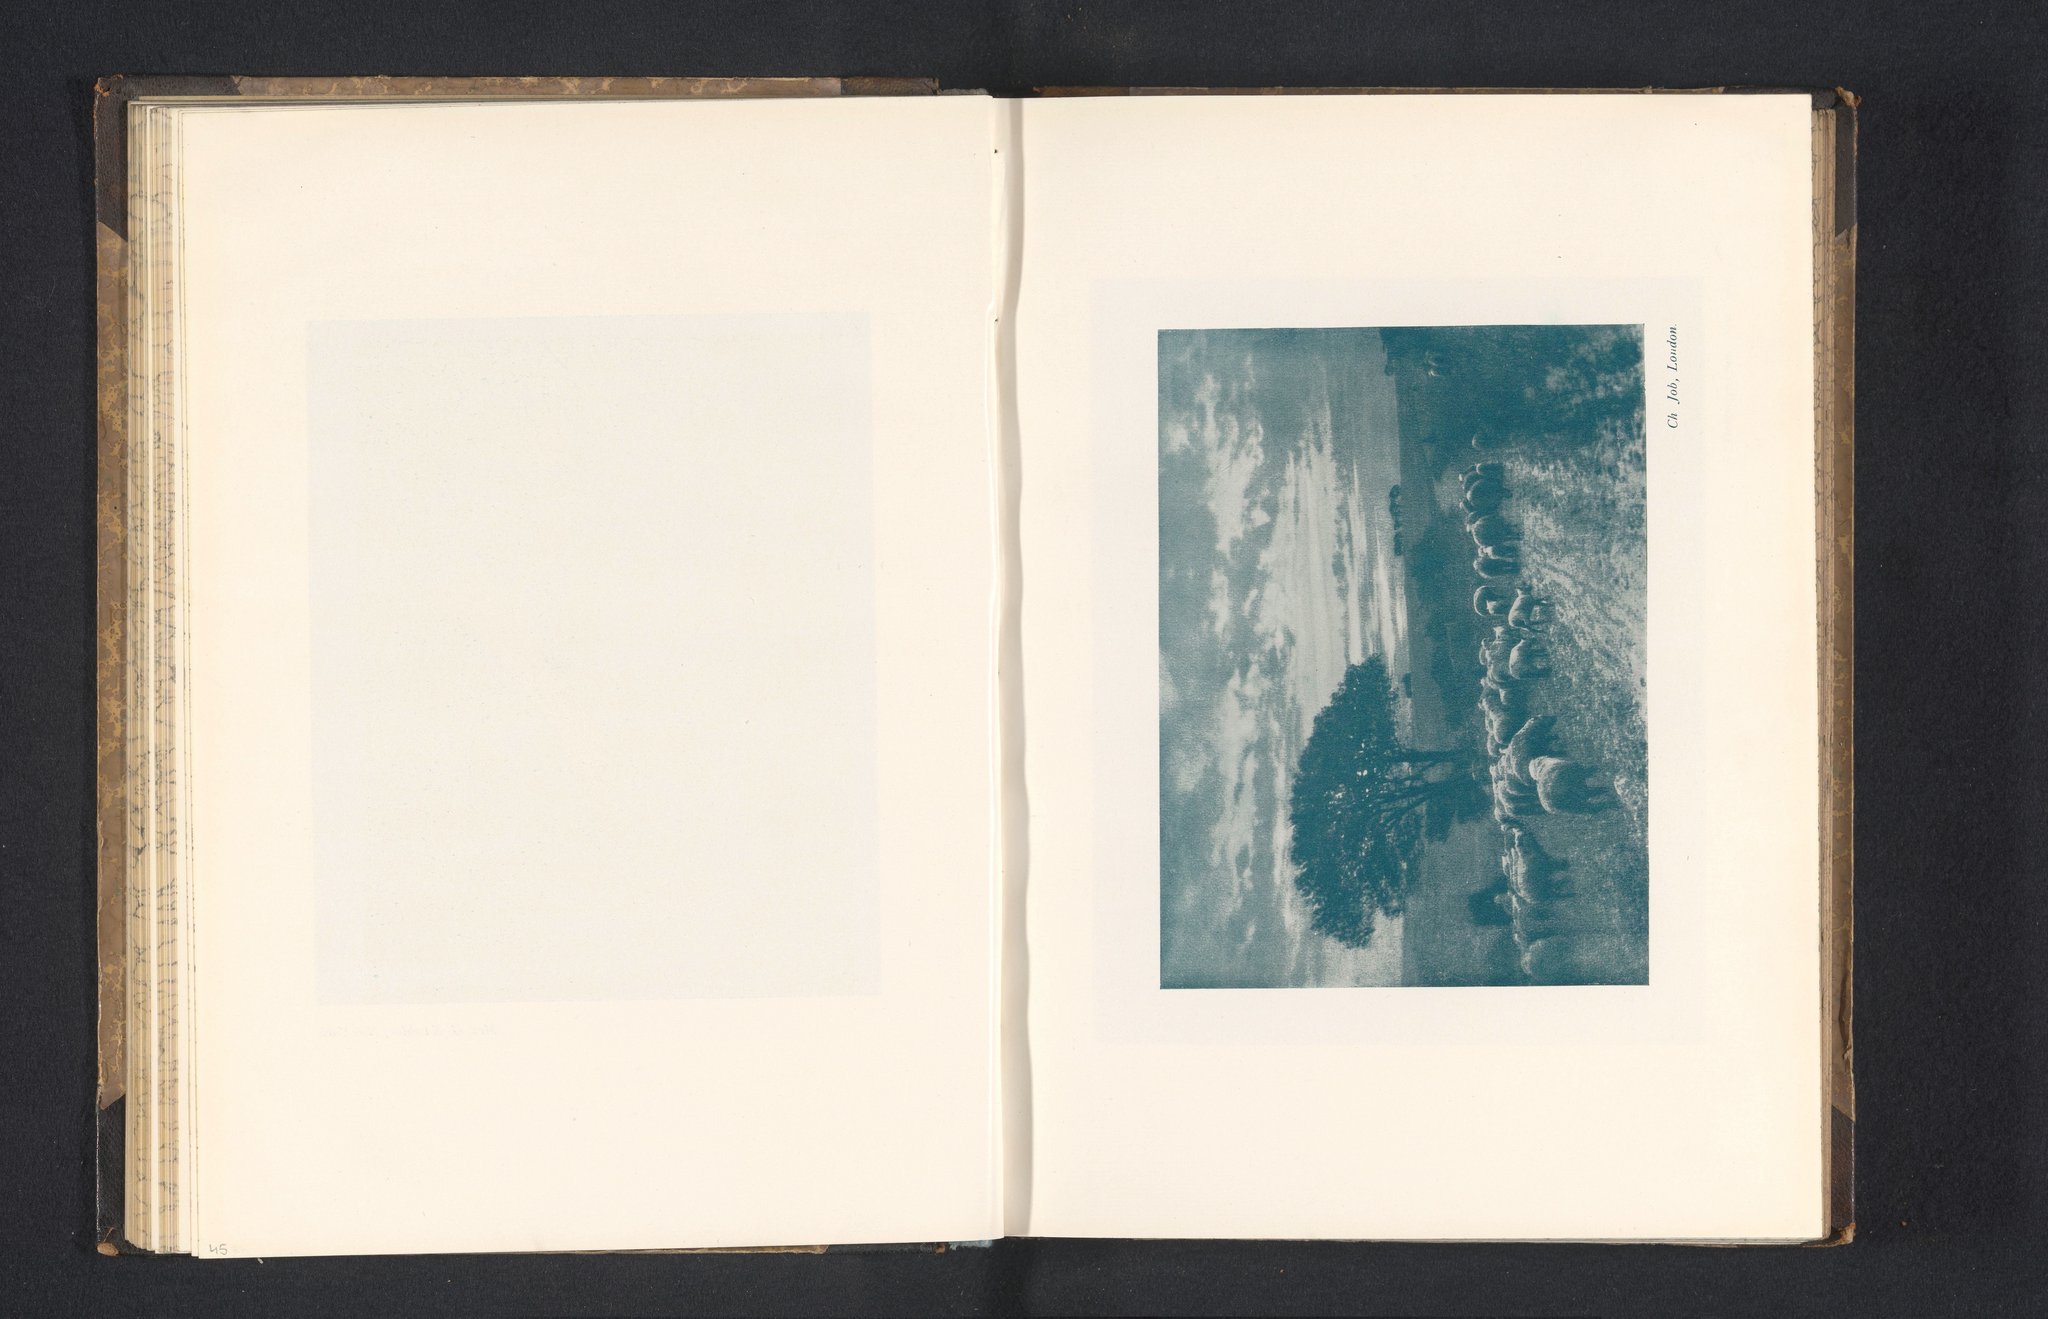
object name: page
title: Landschap met kudde schapen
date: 1898-1903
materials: paper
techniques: autotype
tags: landscapes, sheep, herd, flock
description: Prent op derde ongenummerde pagina na pagina 80.